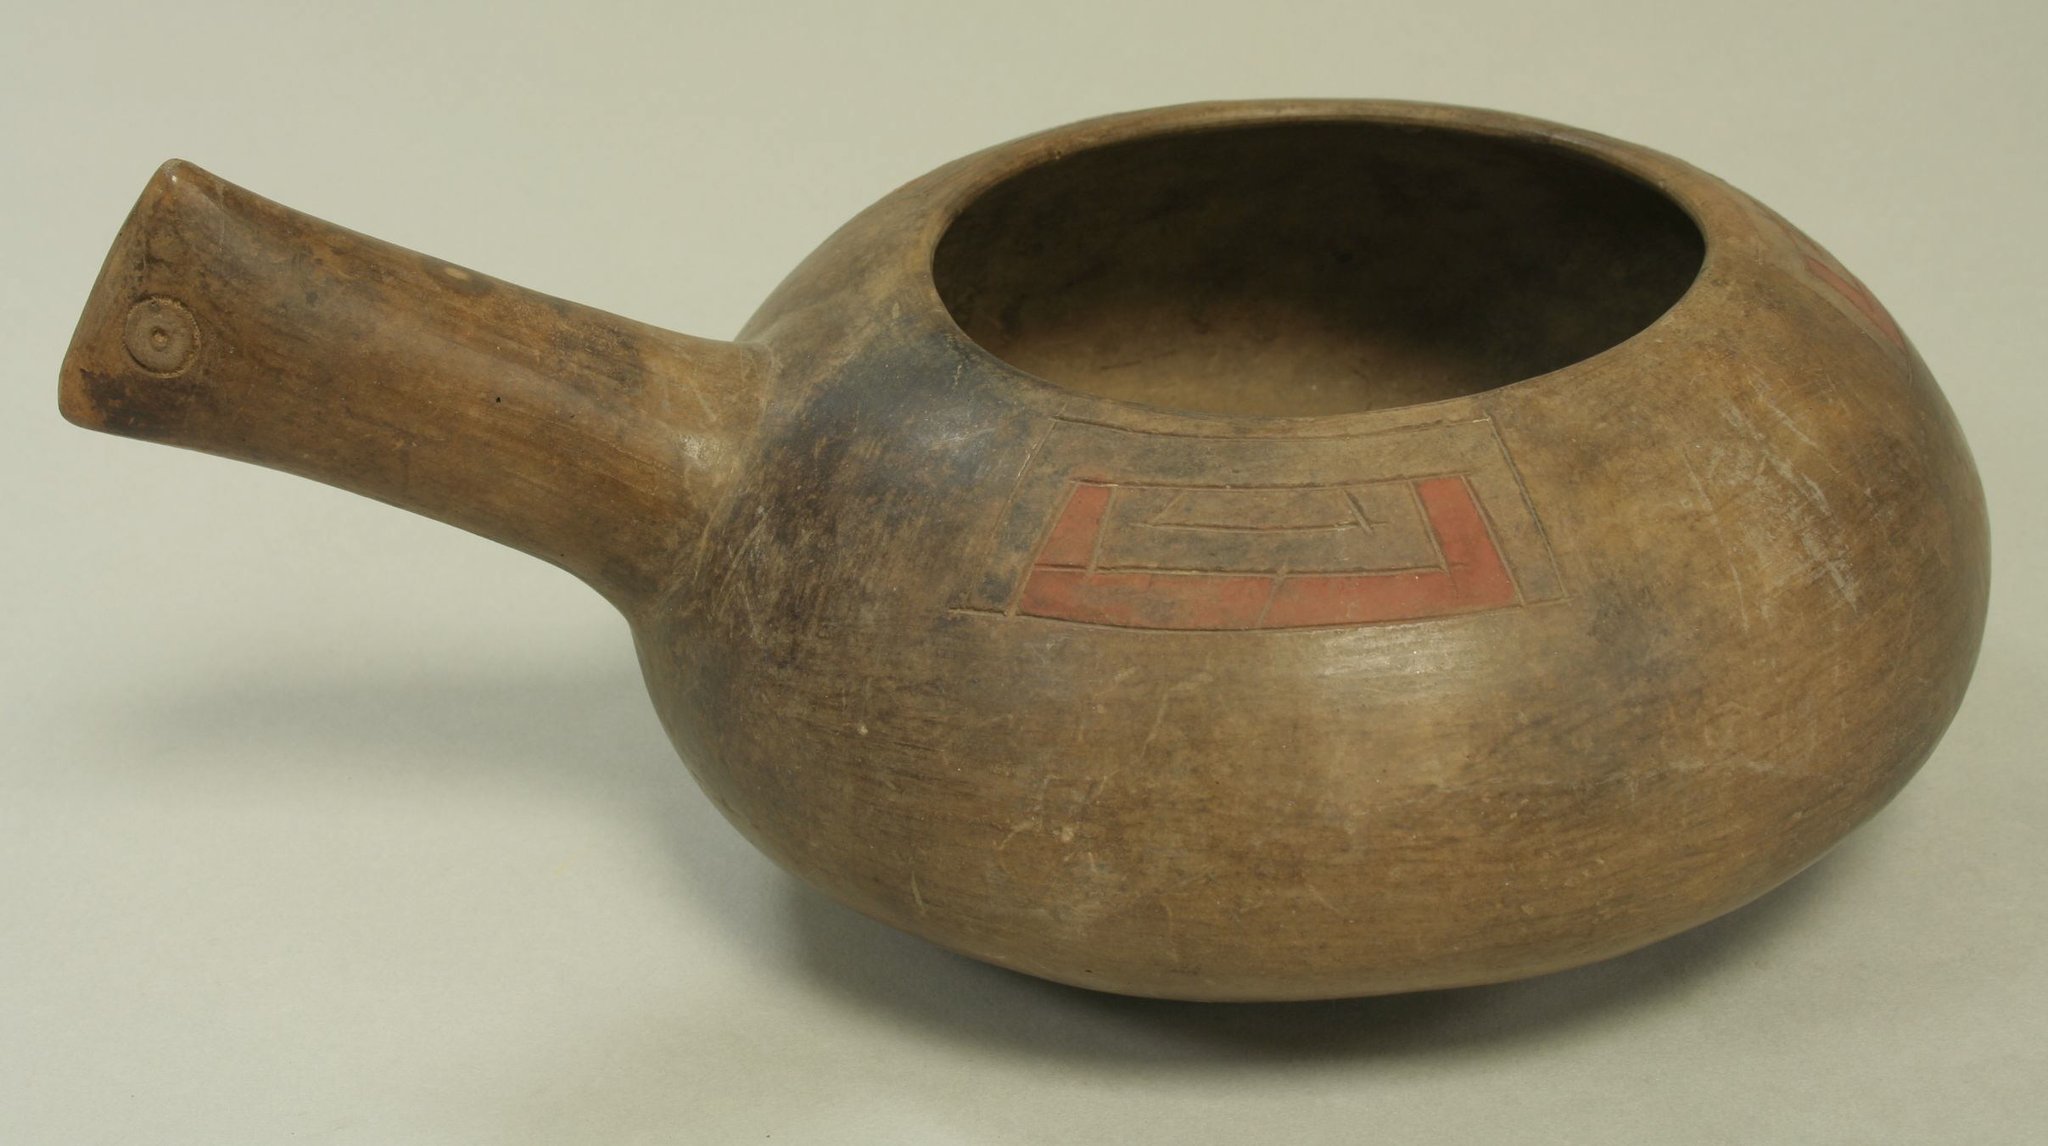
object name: vessel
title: Vessel with Handle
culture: paracas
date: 700-401 BCE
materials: ceramic, pigment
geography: peru